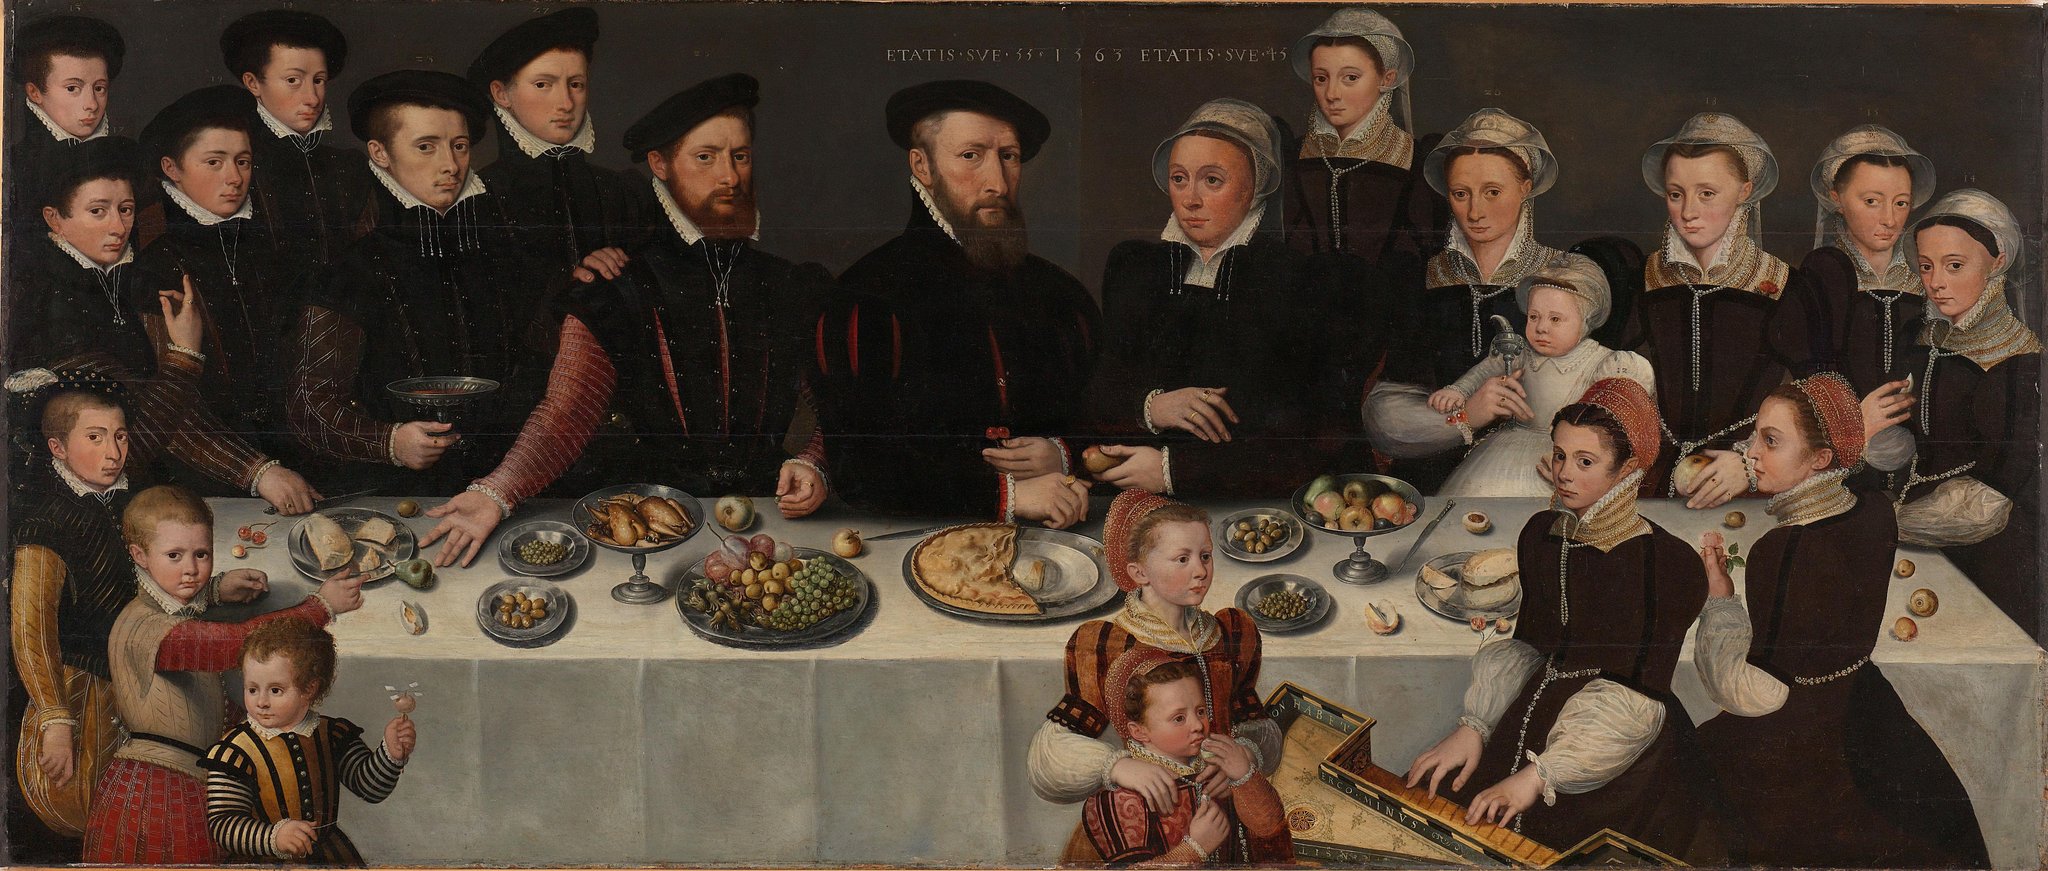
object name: painting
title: Pierre de Moucheron (1508-67), his Wife Isabeau de Gerbier, their eighteen Children, their Son-in-Law Allard de la Dale and their first Grandchild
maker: Anonymous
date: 1563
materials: oil, panel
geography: antwerp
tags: spinet, virginal, historical persons - bb - woman, family group, especially parents with their child(ren), historical persons, laid table: table-ware, table-decoration, etc.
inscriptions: inscription: ‘Etatis Sue 55 1563 / Etatis sue 45’, inscription: ‘Omnia dat Dominus non habet ergo minus’, date: ‘1563’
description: The De Moucheron Family. Antwerp school, 1563. Pierre de Moucheron (1508-1567) and his wife Isabeau de Gerbier are surrounded by their children and grandchildren. Beside Pierre: his son-in-law and sons - oldest to youngest. The daughters are standing beside their mother, also oldest to youngest. Their ages are written above their heads. Pierre de Moucheron and his equally enterprising sons were active at the start of the Dutch Golden Age. Pierre founded a dynasty of Protestant merchants and ship owners. He ran a trading company in Antwerp. When the city fell to Spain in 1585, the firm moved to Middelburg. The towns of Zeeland and Holland profited immensely from the influx of wealthy refugees from the Southern Netherlands.